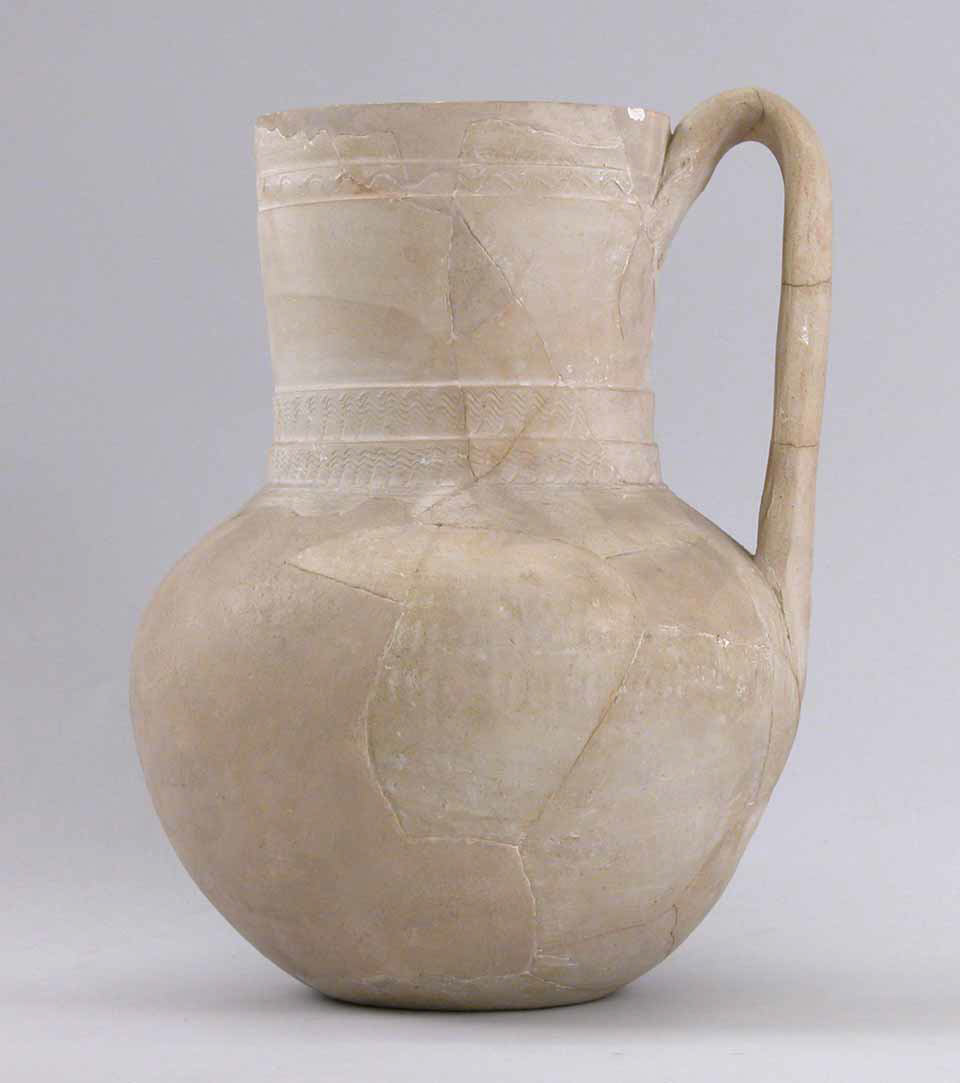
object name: jug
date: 801-900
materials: earthenware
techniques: incising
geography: iran